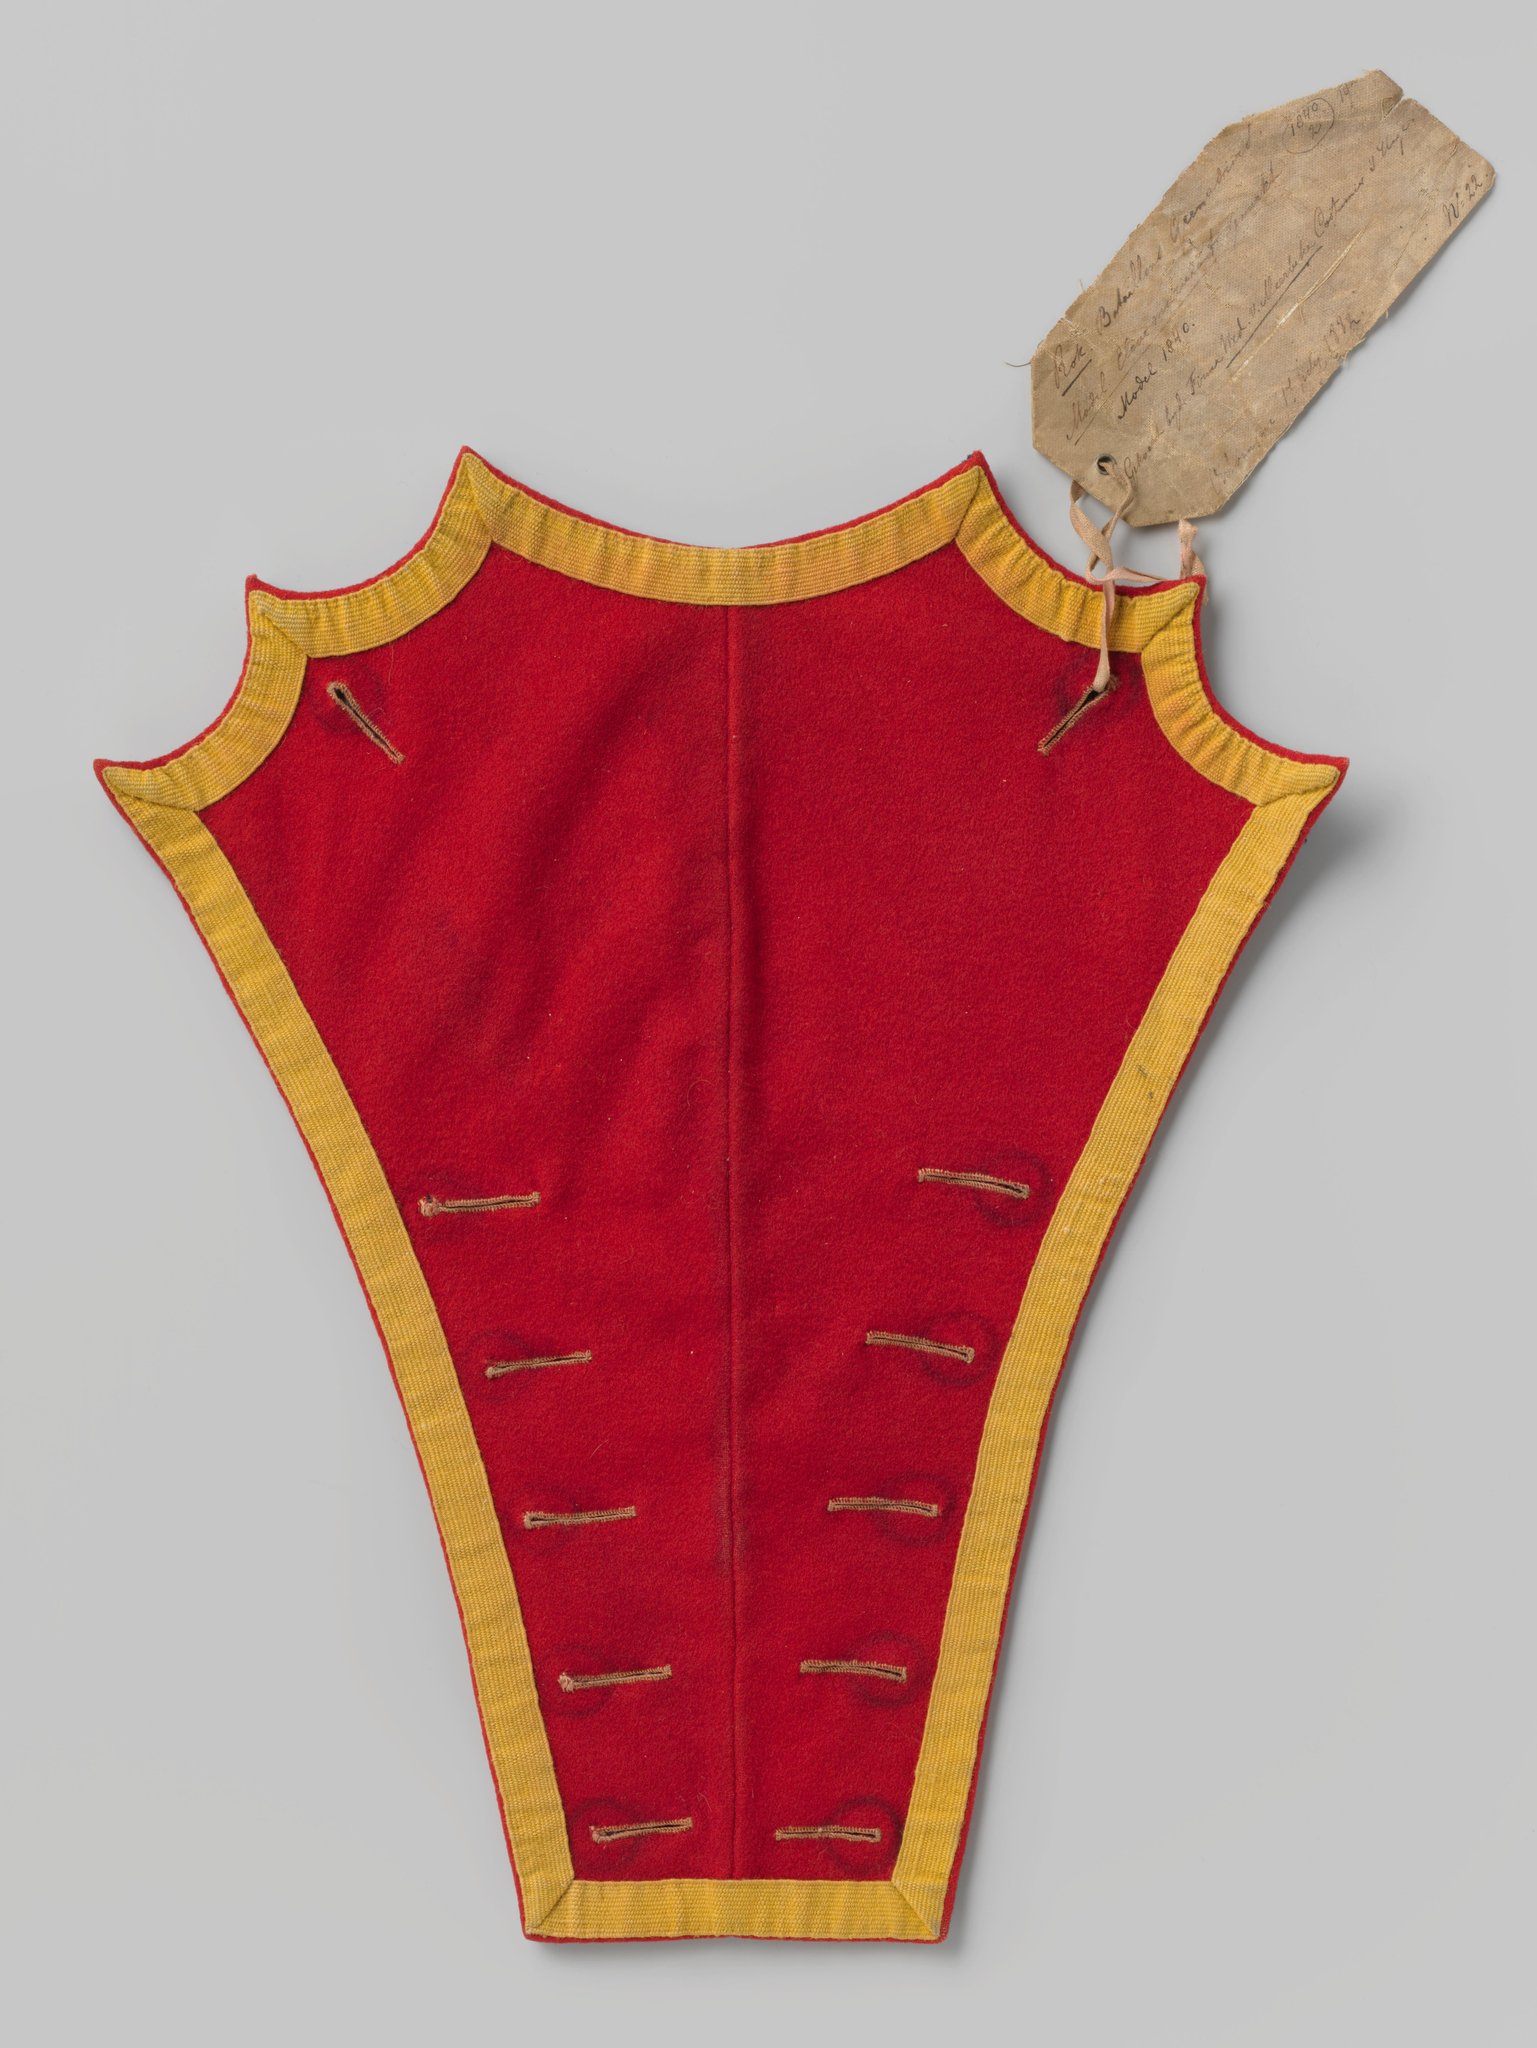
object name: borstklep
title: Een borstklep of plastron van rode stof met gele bies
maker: Anonymous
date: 1840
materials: textile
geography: netherlands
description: Een borstklep of plastron van rode stof met gele bies. Vermoedelijk voor een eleve-muzikant van de muziekkapel der grenadiers (de latere Koninklijke Militaire Kapel).